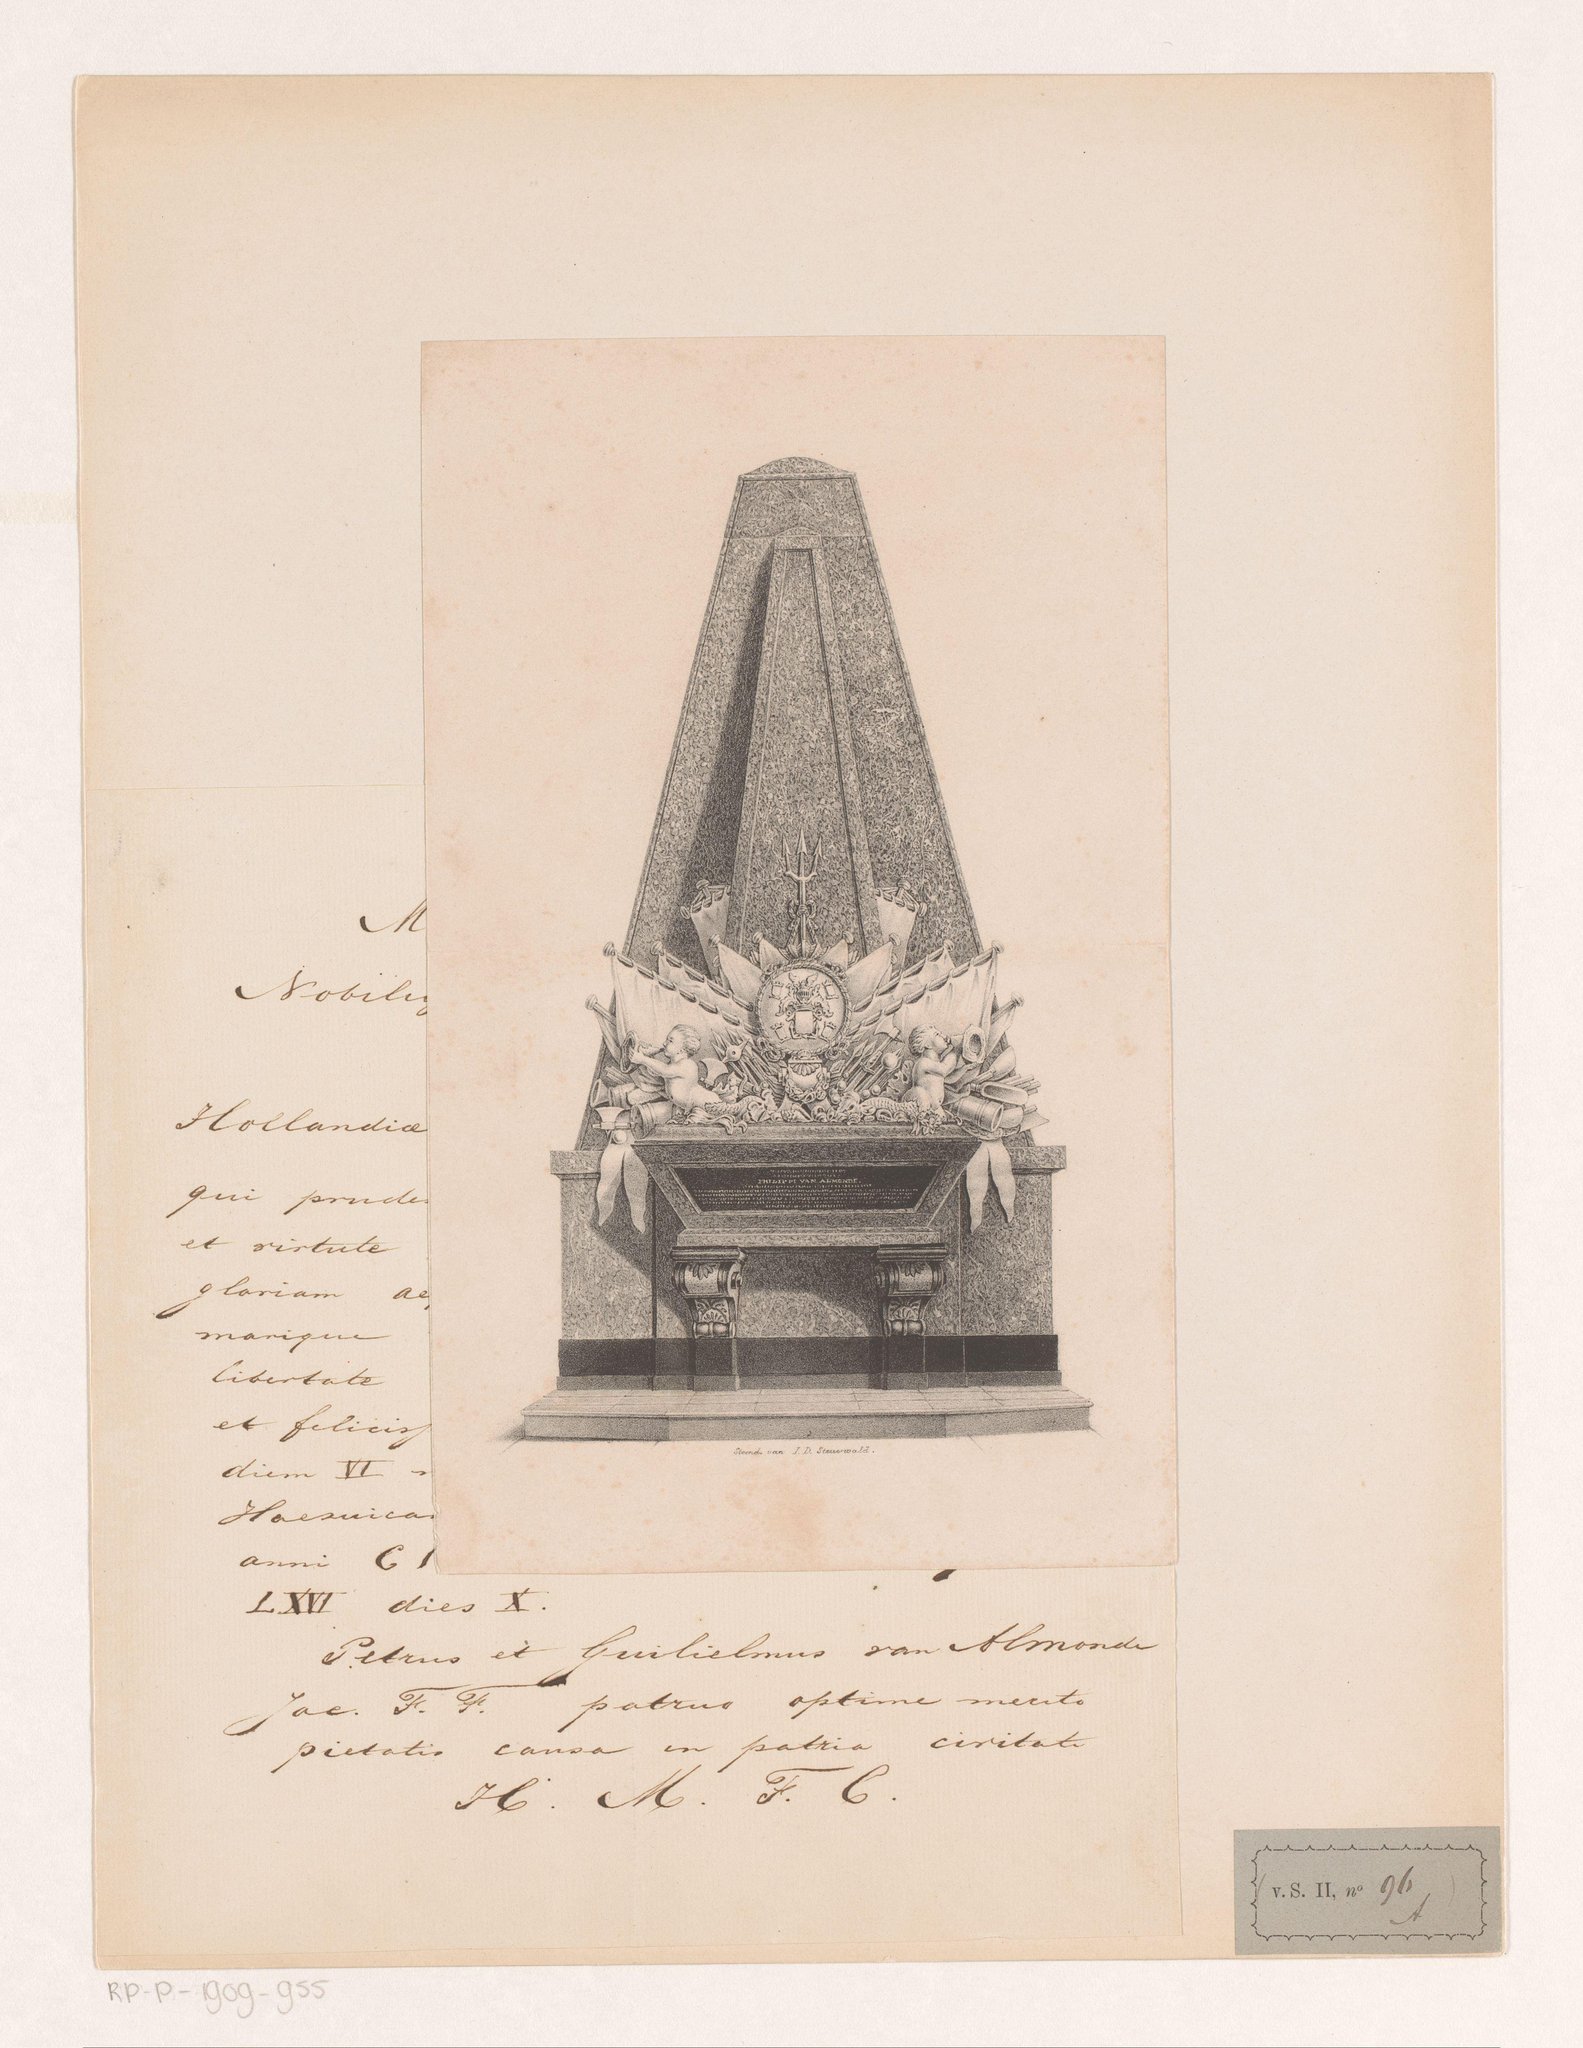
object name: print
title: Grafmonument van Philips van Almonde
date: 1822-1863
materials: paper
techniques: lithograph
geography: netherlands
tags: grave, tomb, brielle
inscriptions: collector's mark: Lugt 2228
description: Het grafmonument van Philips van Almonde in de Grote of Sint-Catharijnekerk in Brielle. Met vlaggen, wapens, wapenschild en putti met vissenstaarten blazend op schelpen.